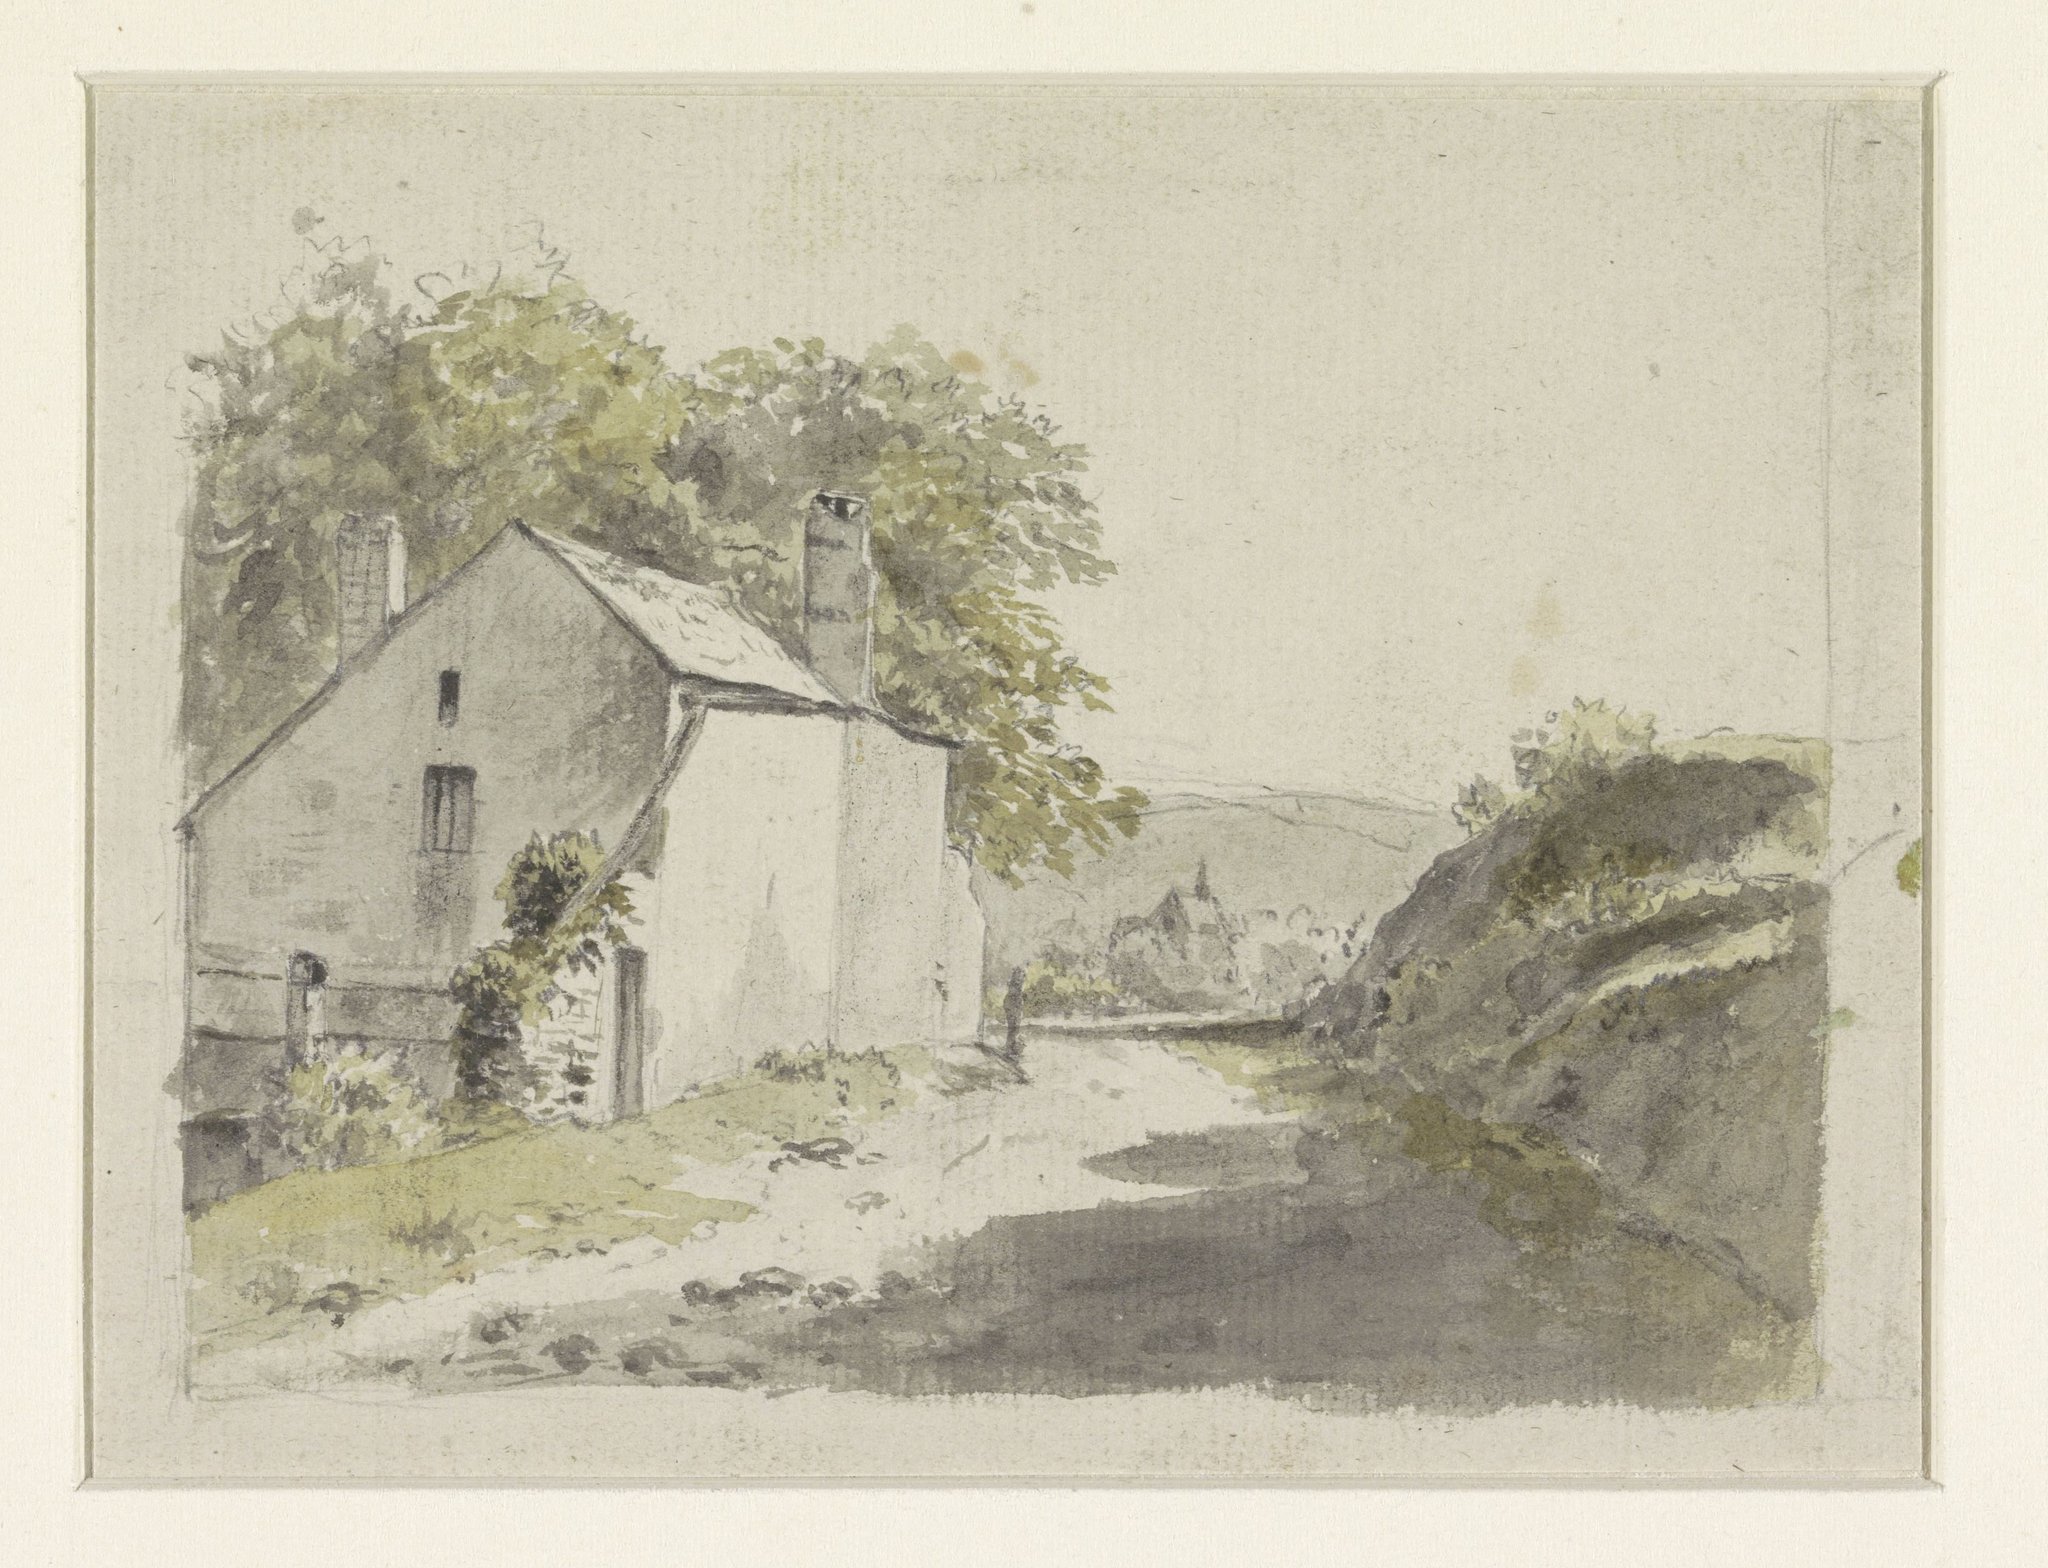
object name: design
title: Landschap met huis aan weg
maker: hendrik jozef franciscus van der poorten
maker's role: draughtsman, print maker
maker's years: 1789-1874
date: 1799-1814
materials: paper, pencil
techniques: brush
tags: farm or solitary house in landscape